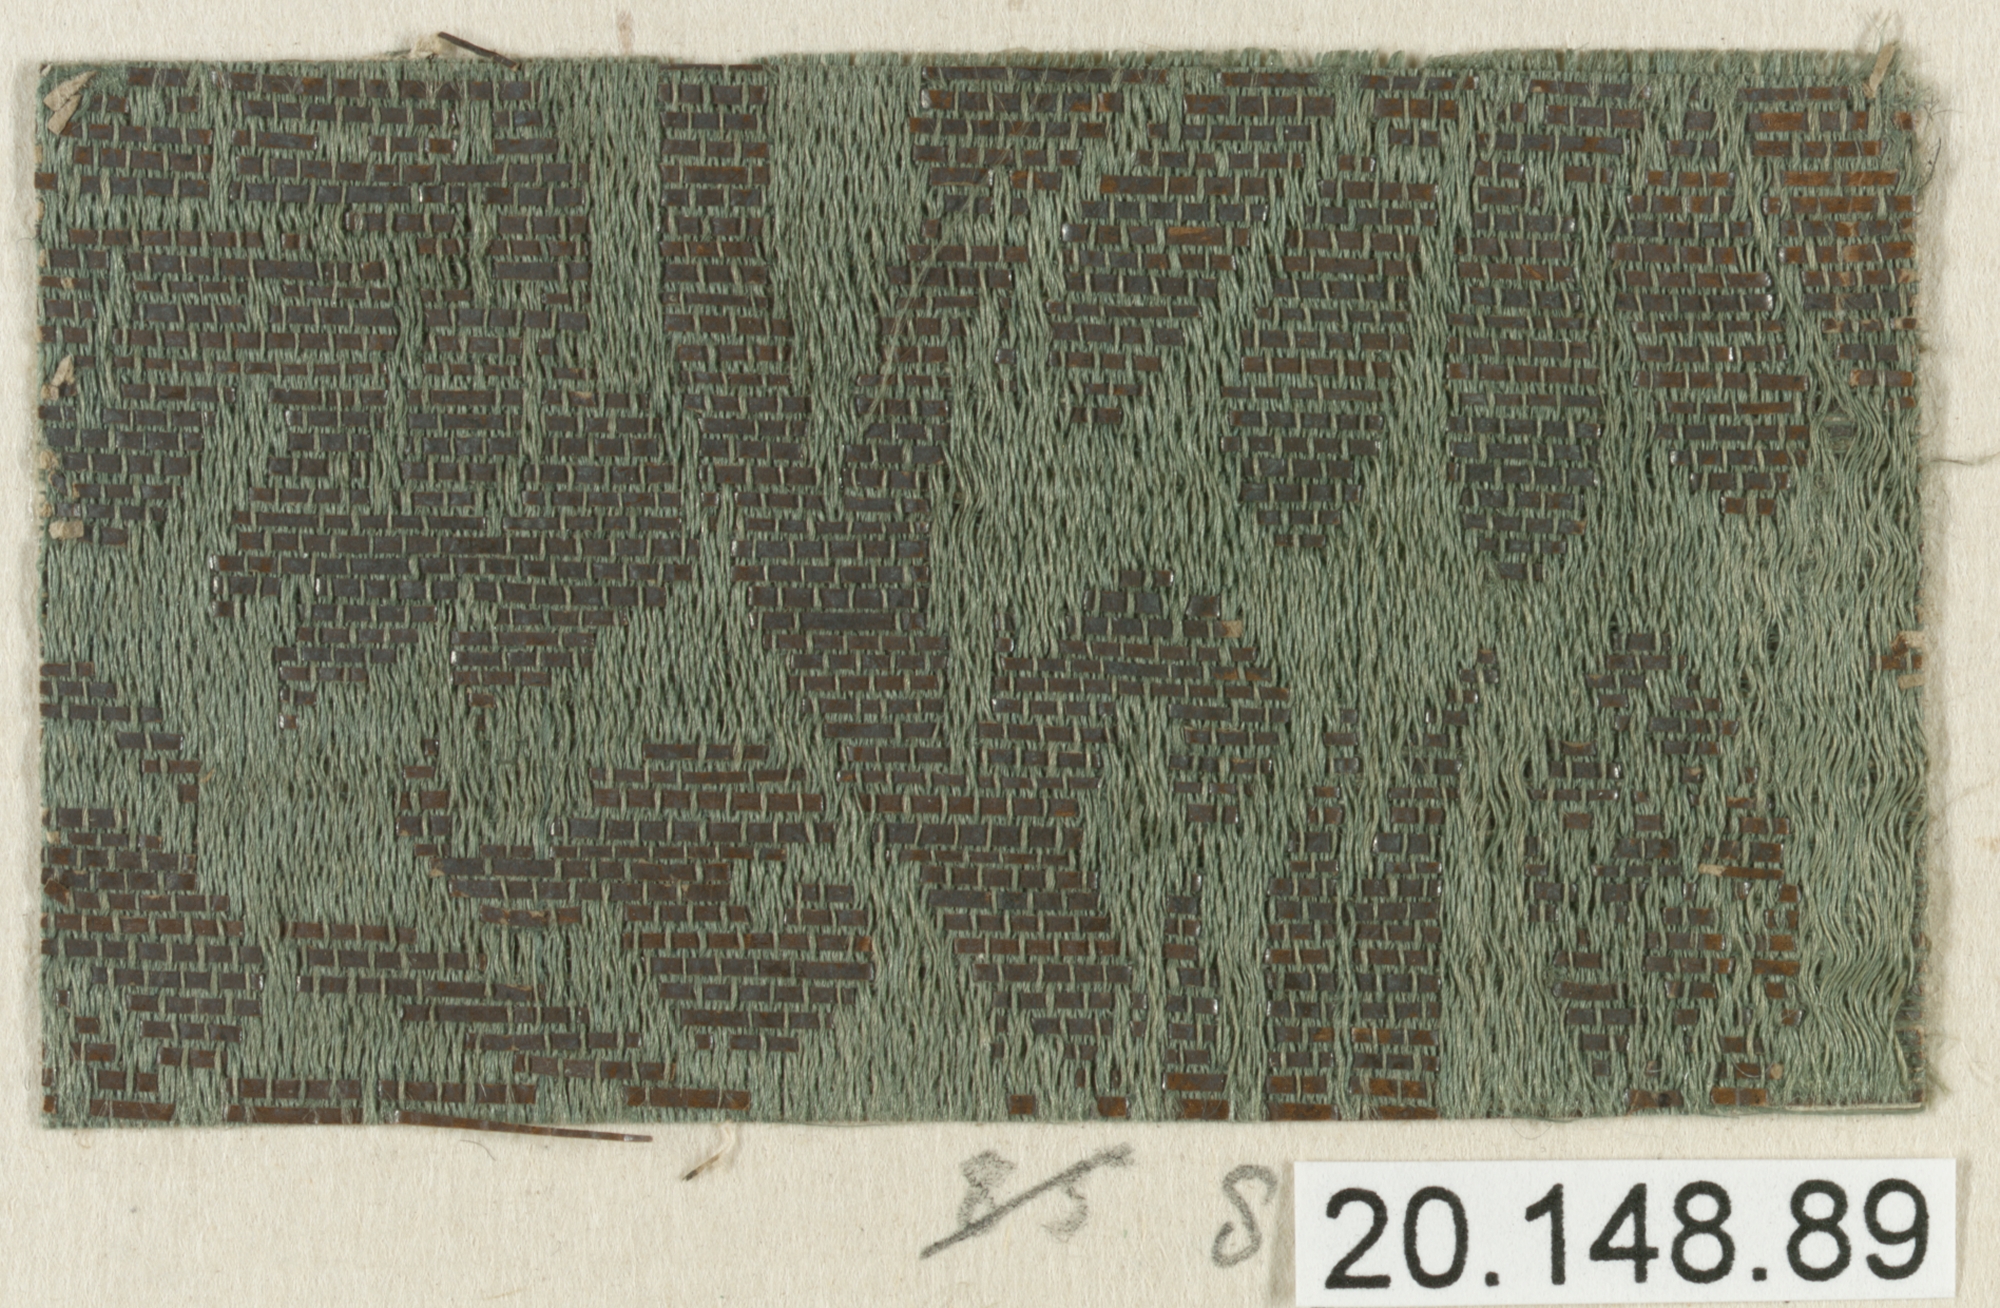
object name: piece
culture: japanese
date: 1501-1600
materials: silk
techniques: compound weave